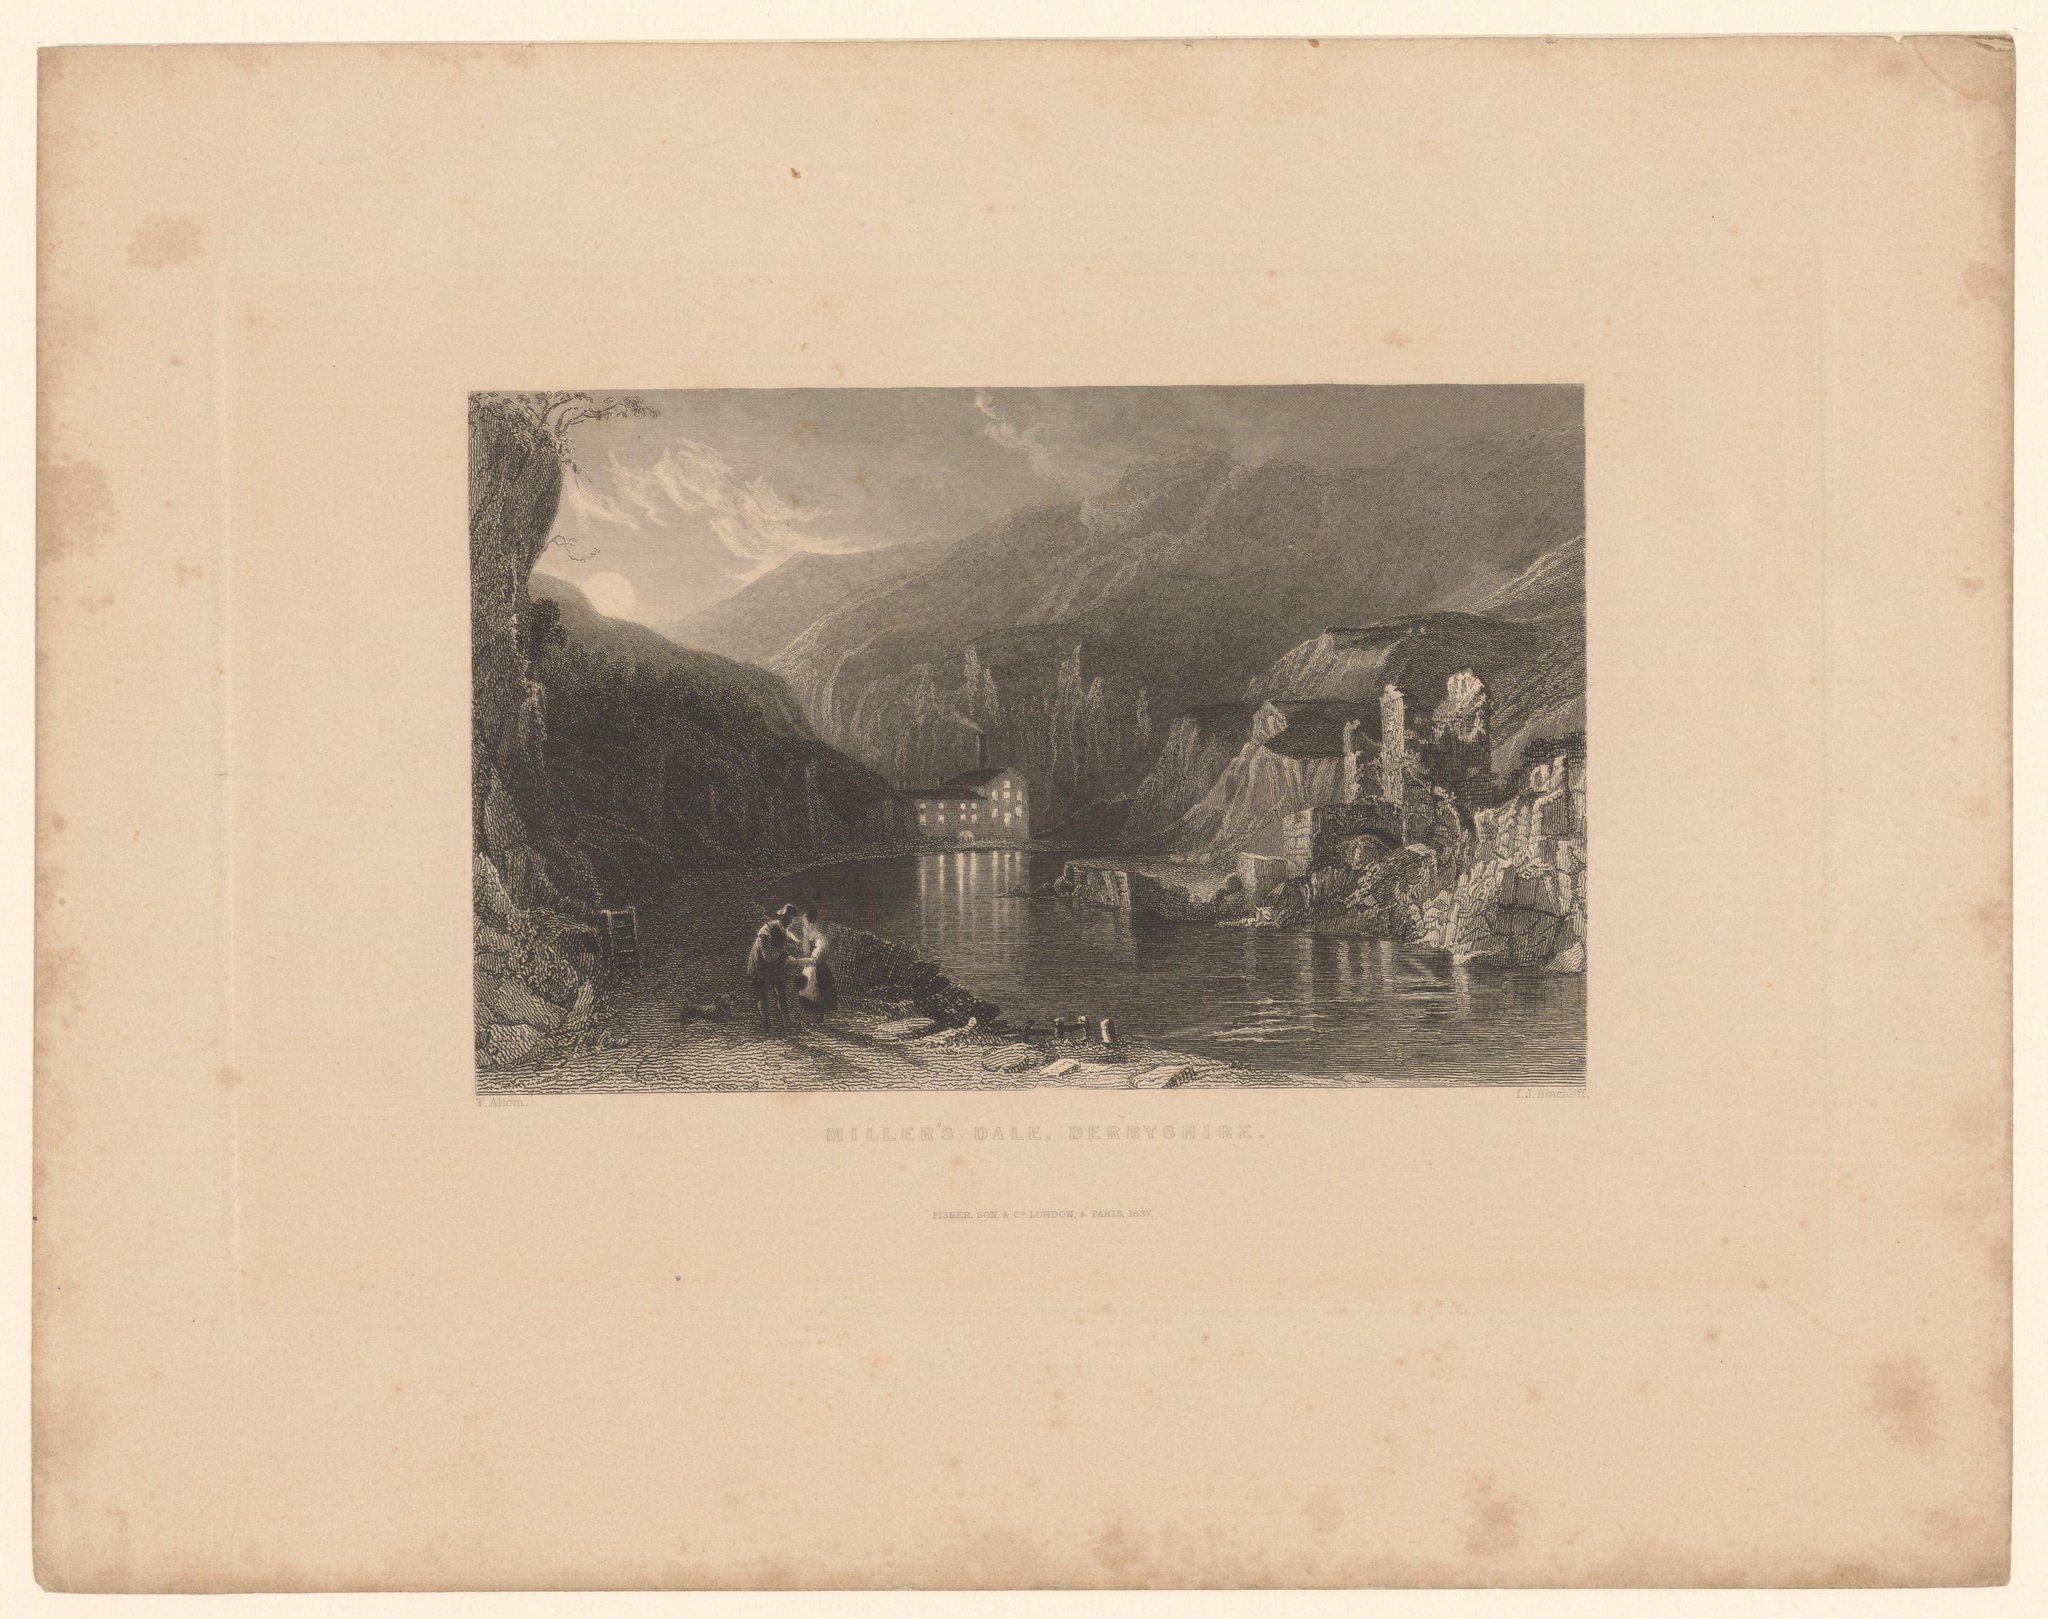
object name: print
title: Miller's Dale, Derbyshire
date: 1837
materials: paper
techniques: engraving, etching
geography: london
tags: river, (high) hill (+ landscape with figures, staffage)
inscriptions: collector's mark: Lugt 2228